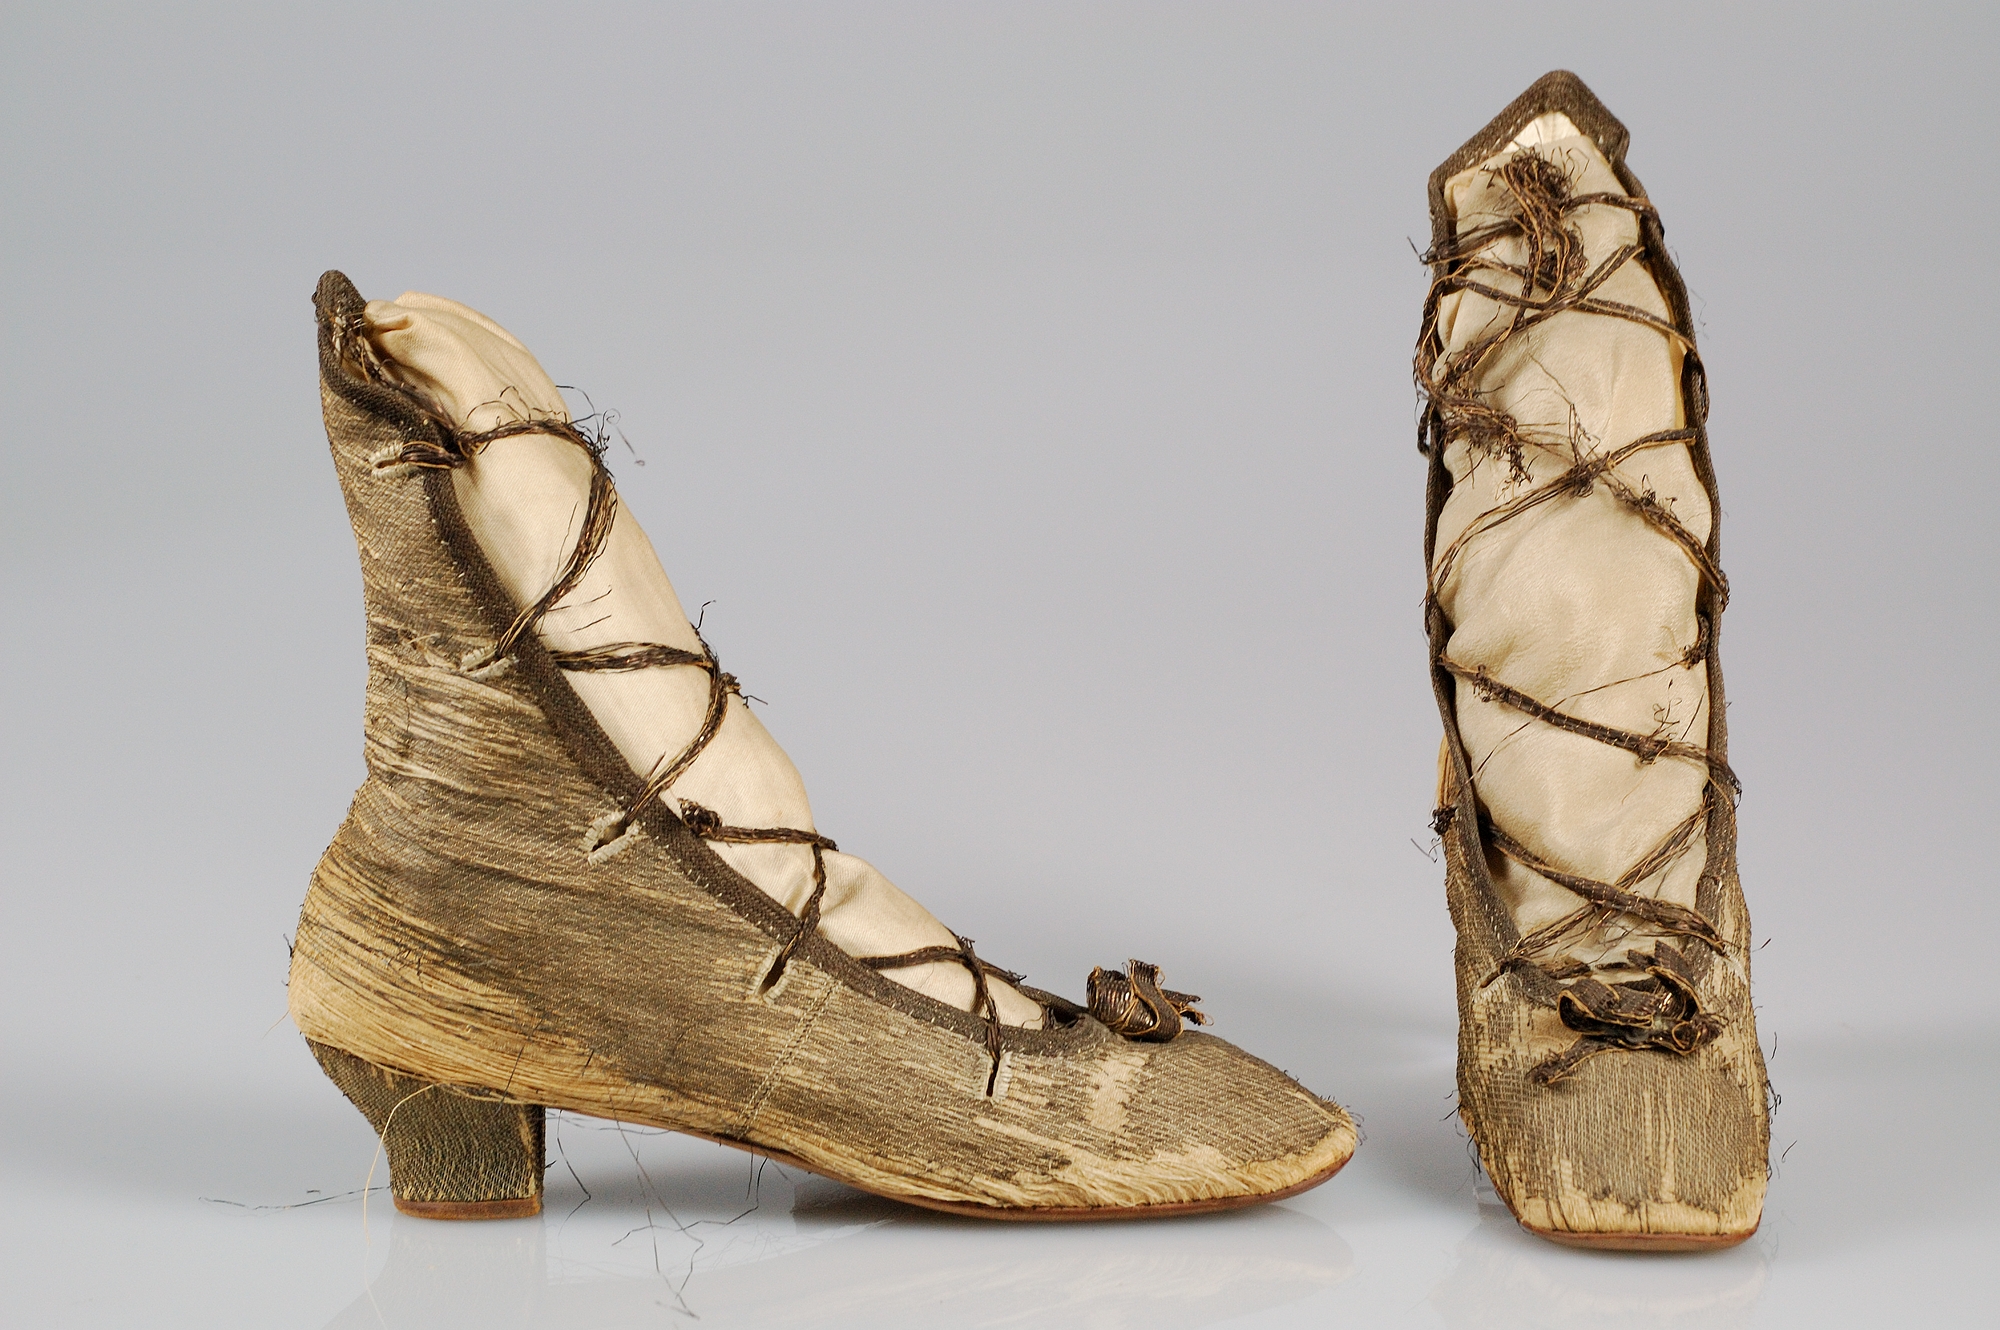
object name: evening boot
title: Evening boots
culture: french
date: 1860-1869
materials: linen